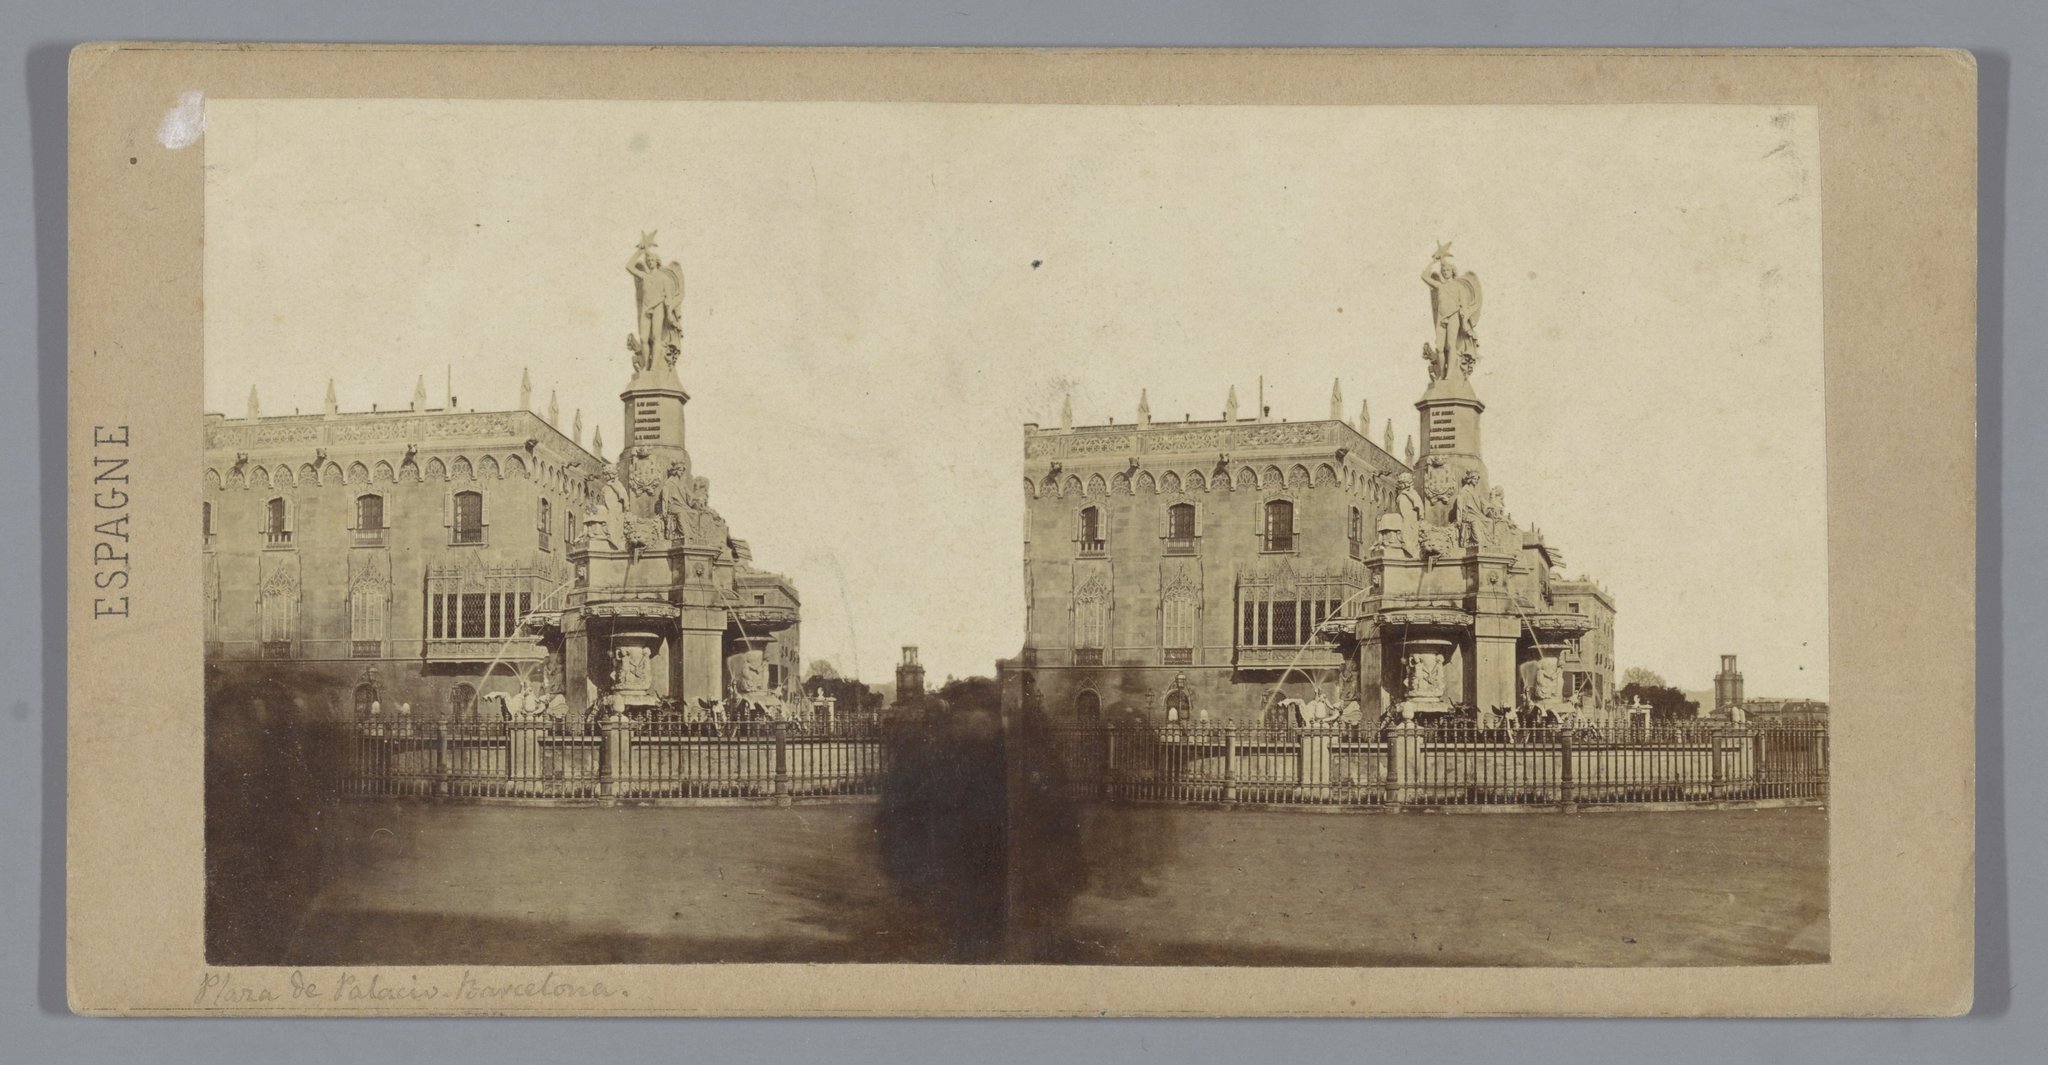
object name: stereograph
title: Gezicht op de Genio Catalán-fontein te Barcelona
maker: Anonymous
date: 1850-1880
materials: cardboard, photographic support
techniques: albumen print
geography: barcelona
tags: ornamental fountain, façade (of house or building)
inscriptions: number: ‘A 1’, inscription: ‘Plaza del Palacio Real, à Barcelonne.’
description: Gezicht op de Genio Catalán-fontein te Barcelona. Op de achtergrond het Palacio del Virrey.